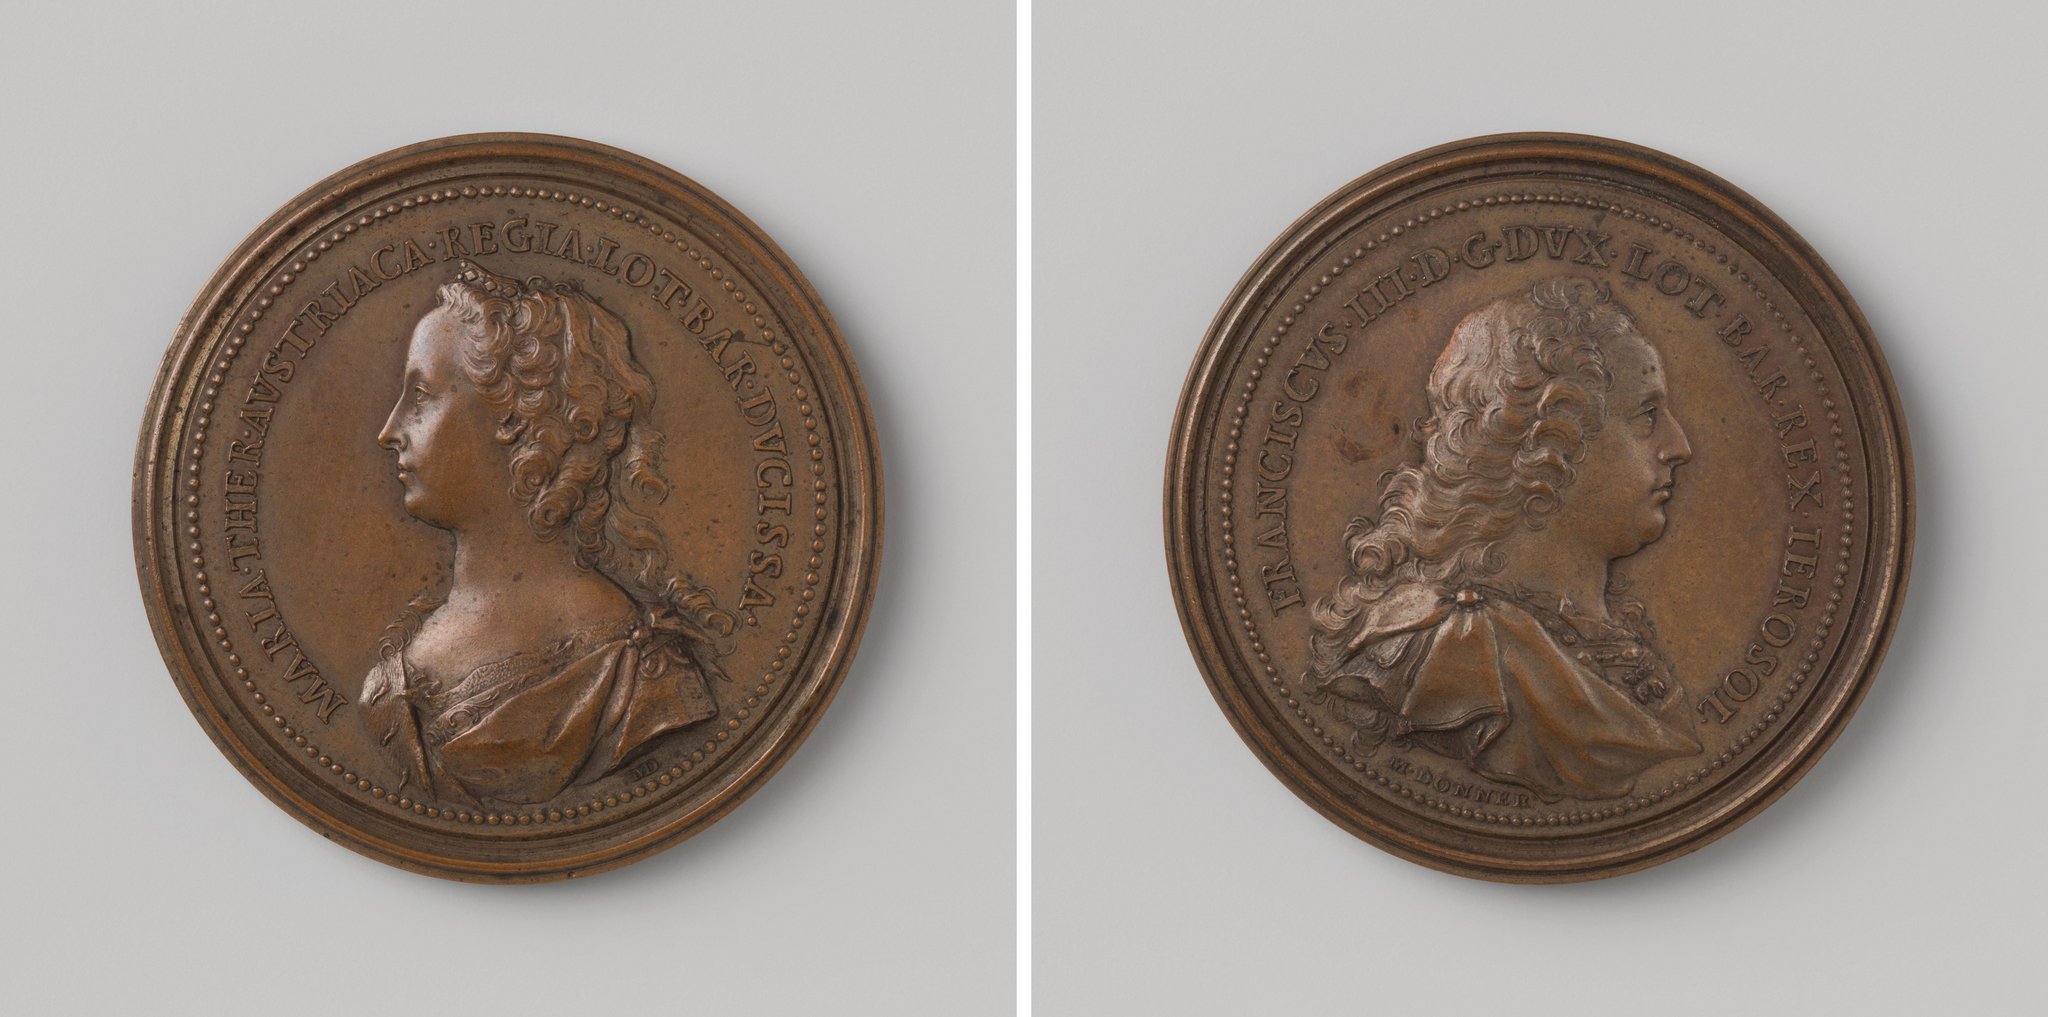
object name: history medal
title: Huwelijk van Frans Stephen, hertog van Lotharingen en Maria Theresia, aartshertogin van Oostenrijk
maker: matthäus donner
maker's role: sculptor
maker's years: 1704-1756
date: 1736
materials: bronze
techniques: striking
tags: maria theresia (rooms-duits keizerin), frans i stefan (duits keizer)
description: Bronzen penning. Voorzijde: borststuk vrouw met diadeem binnen omschrift. Keerzijde: borststuk man binnen omschrift